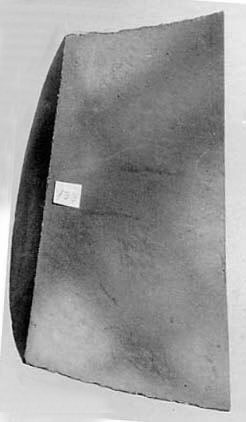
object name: fragment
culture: russian, siberia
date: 1902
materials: jade